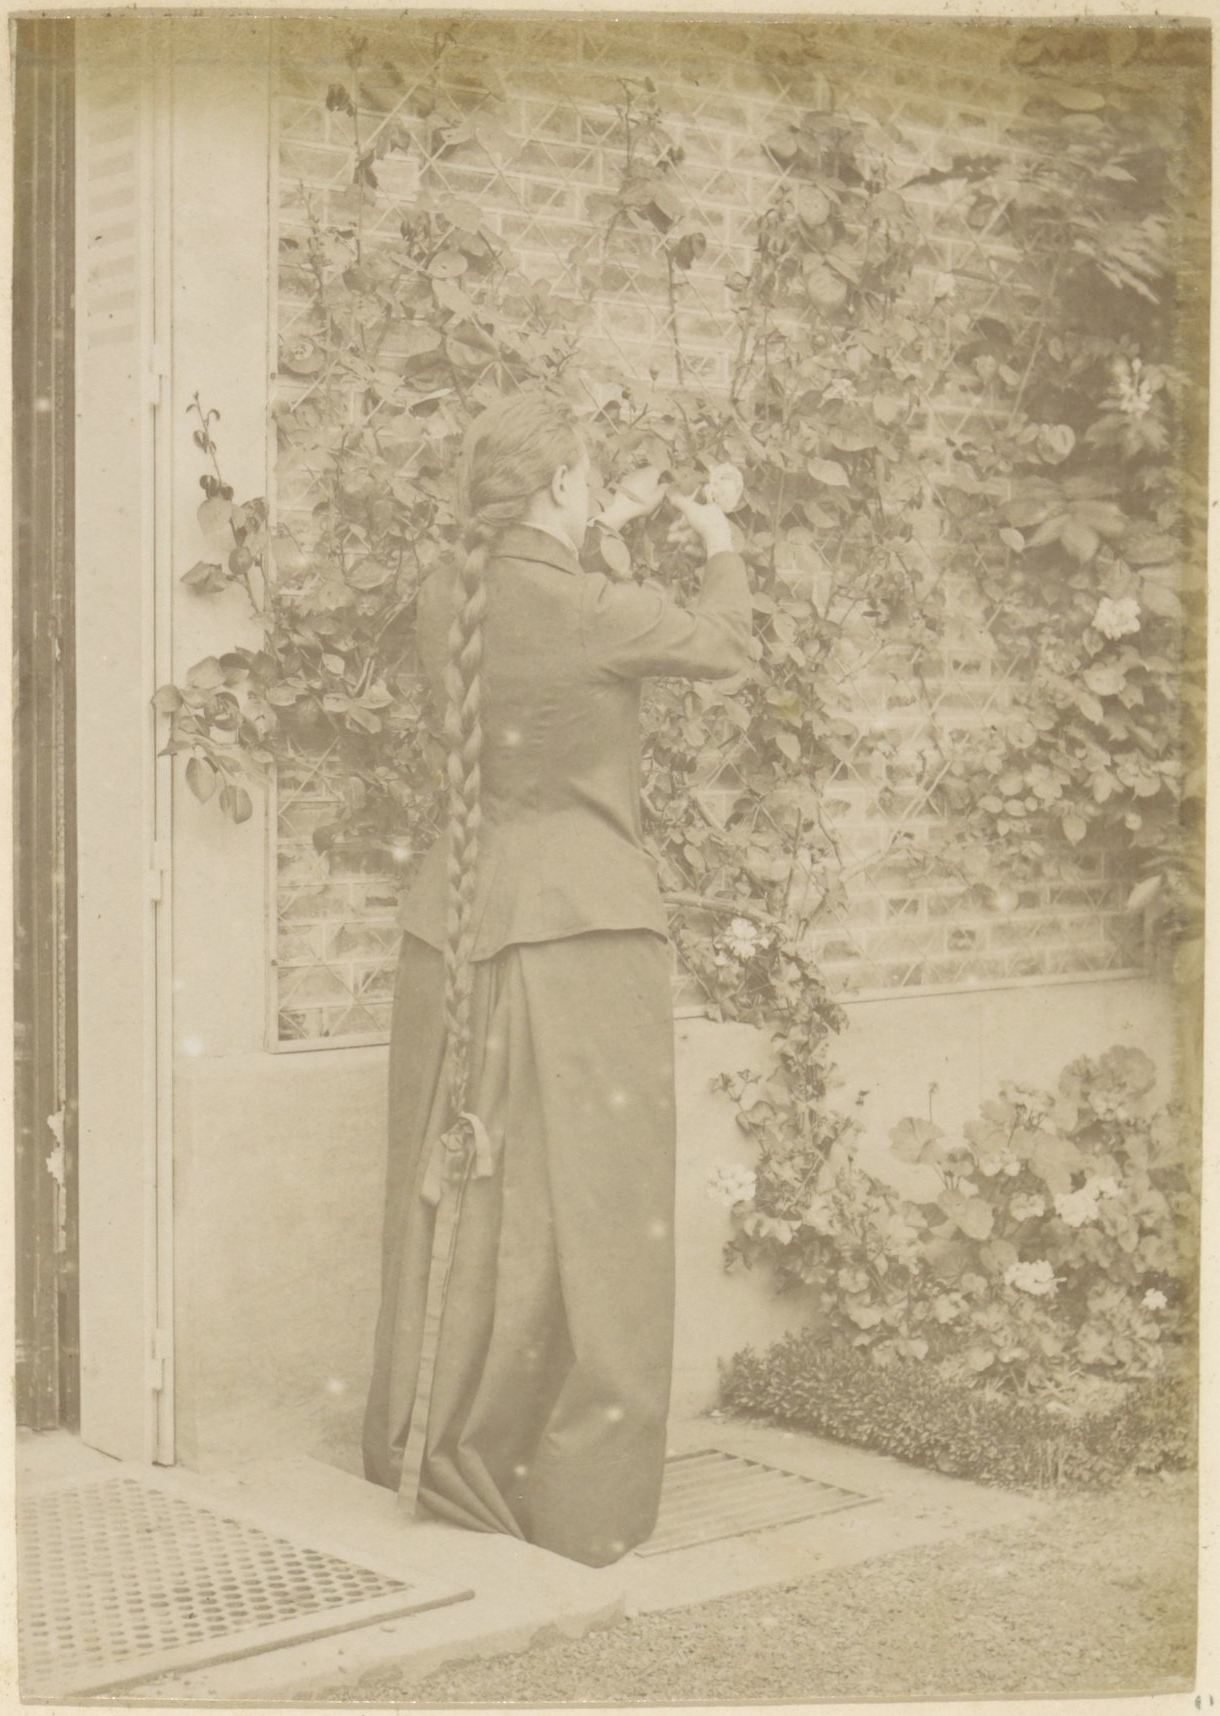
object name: photograph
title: Portret van een Franse vrouw met een zeer lange gevlochten staart, rozen knippend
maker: Anonymous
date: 1900-1910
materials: paper, photographic support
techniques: albumen print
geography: france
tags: adult woman, border, ribbon, braid, flowers: rose, france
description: Onderdeel van Fotoalbum van een Franse amateurfotograaf met opnames van een familie, distilleerderij Delizy & Doistau Fils, het leger en bezienswaardigheden in Frankrijk.